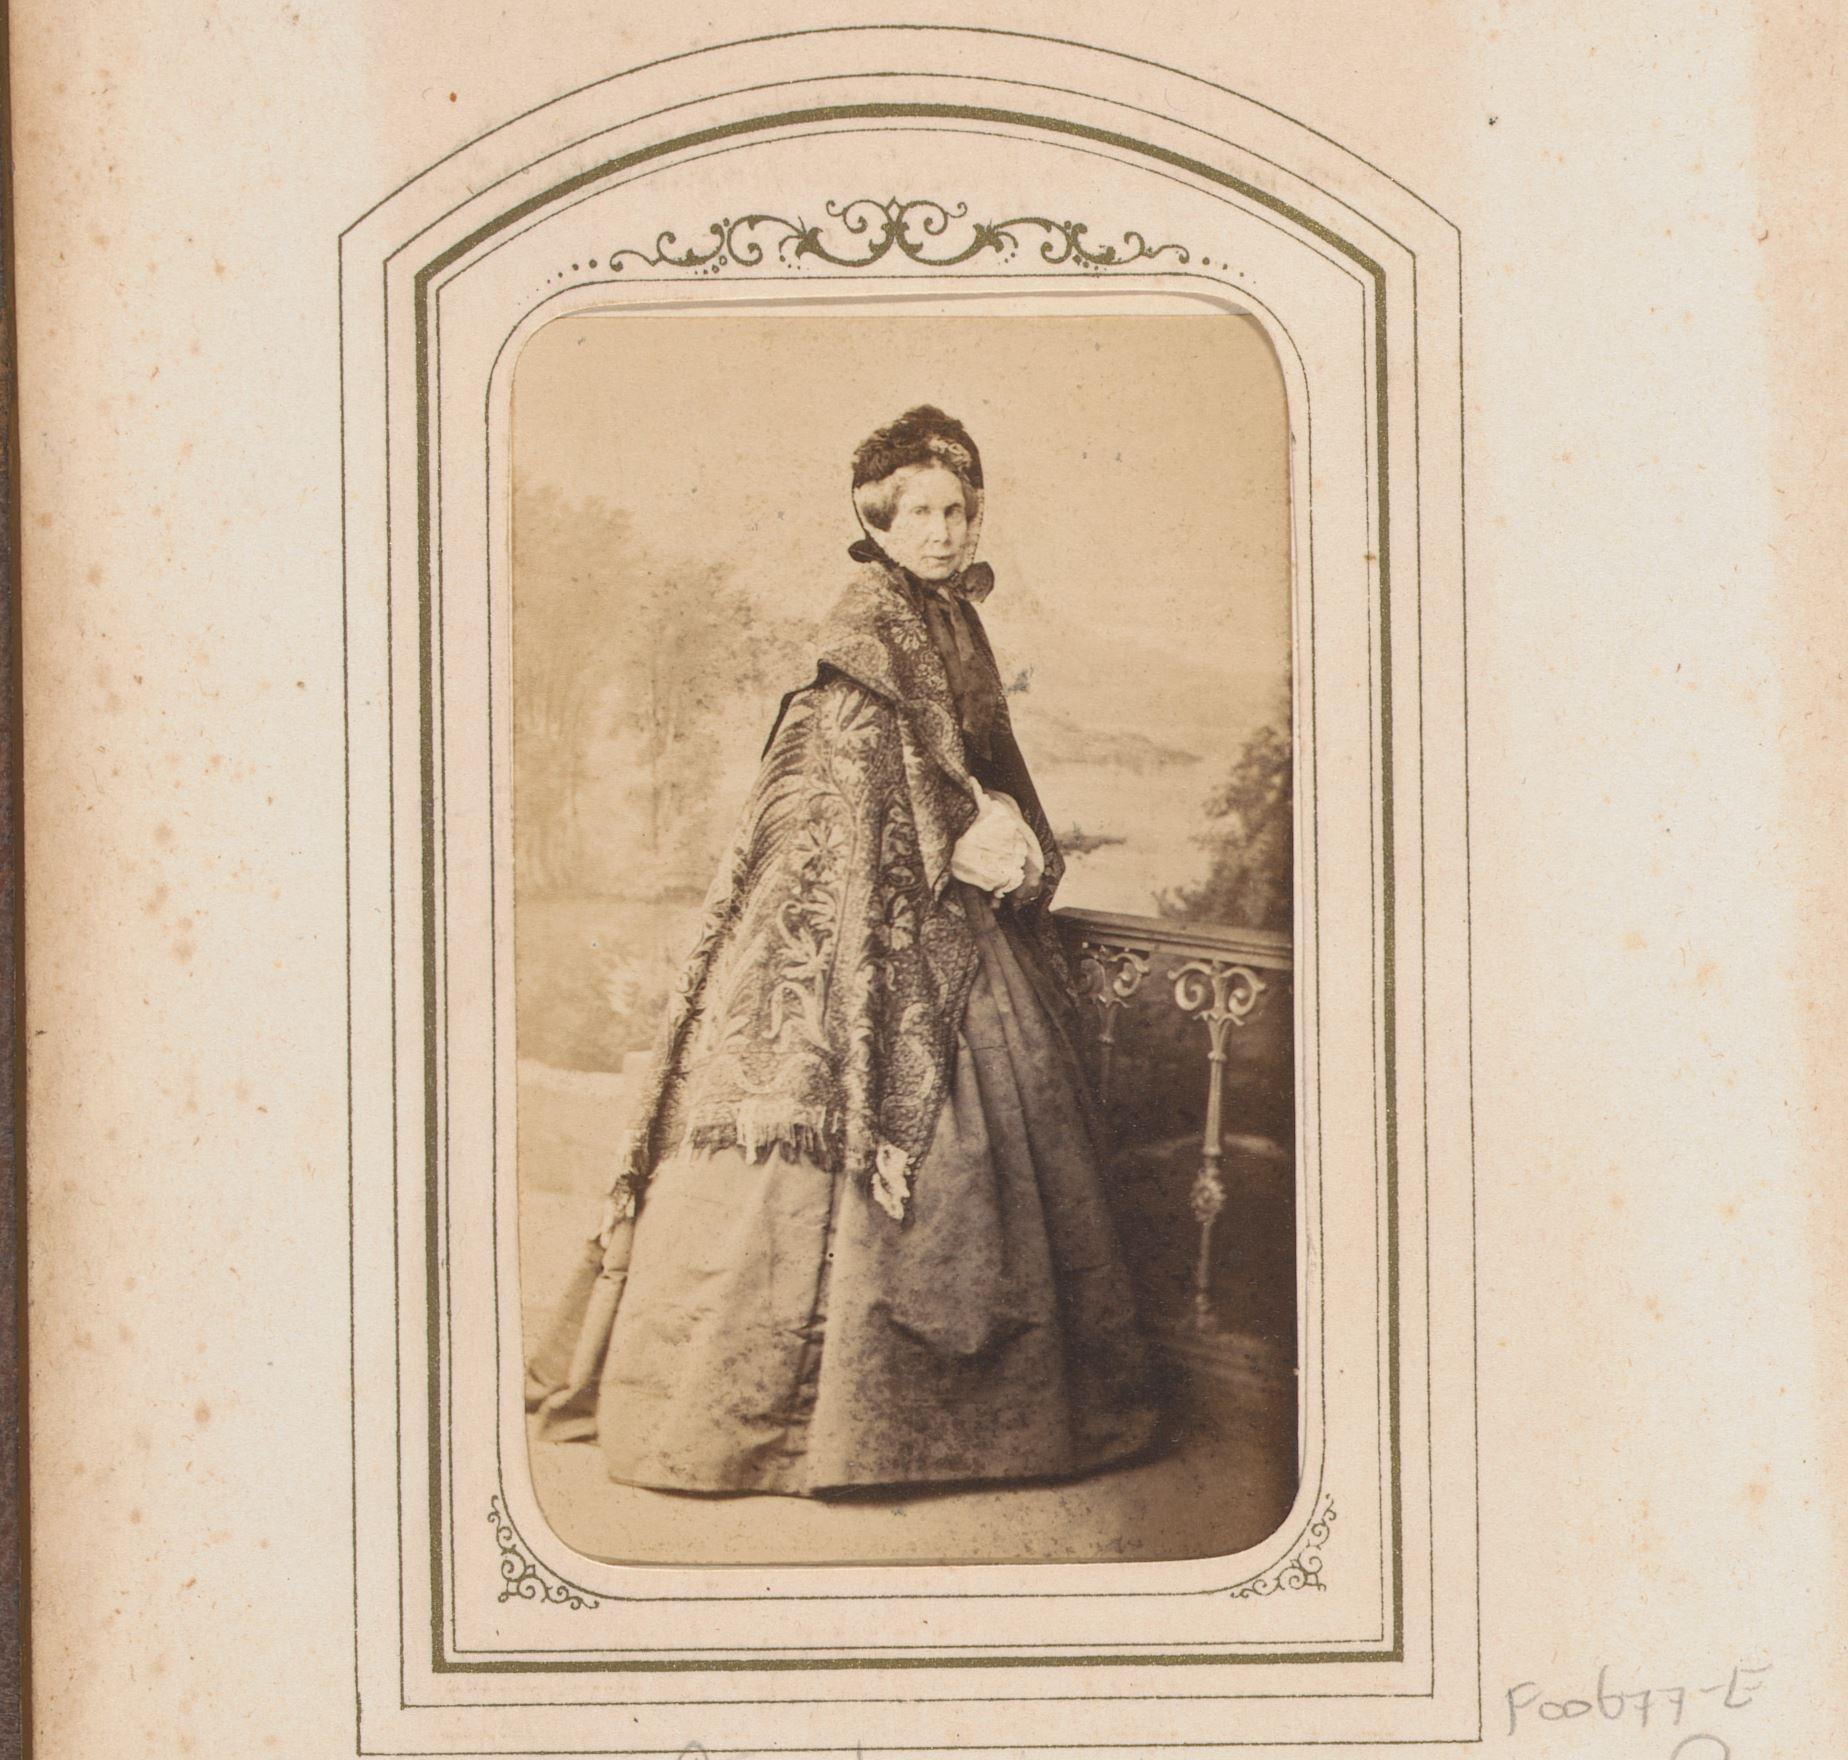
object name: photograph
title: Portret van Louise van Pruisen, prinses der Nederlanden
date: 1860-1870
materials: cardboard, photographic support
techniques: albumen print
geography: netherlands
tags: historical persons - bb - woman, princess, netherlands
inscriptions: inscription: ‘L. Haase & Comp./ Königl. Hof-Photographen/ un Hof-Photographen I. K. Hoheit der Frau/ Kronprinzessin v. Preussen./ Berlin/ 178. Friedrichsstr. 178./ Breslau/ 10. Tauensienstr. 10.’, annotation: ‘prinses Louise der Nederlanden,/ echtgenote prins Frederik, geb/ prinses van Pruisen (1808-1870)’, inscription: ‘Phot. L. Haase & Comp’